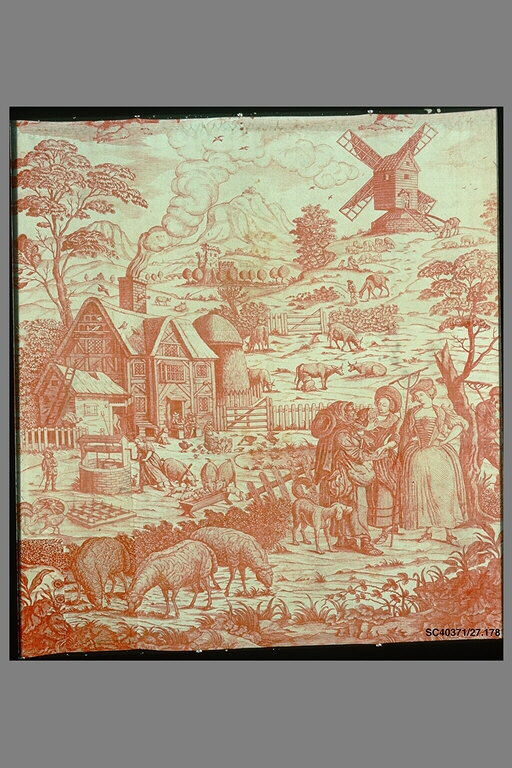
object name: furnishing textile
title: The Fortune Teller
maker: john collins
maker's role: maker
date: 1770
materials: cotton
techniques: weave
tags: animals,houses,windmills,women,trees